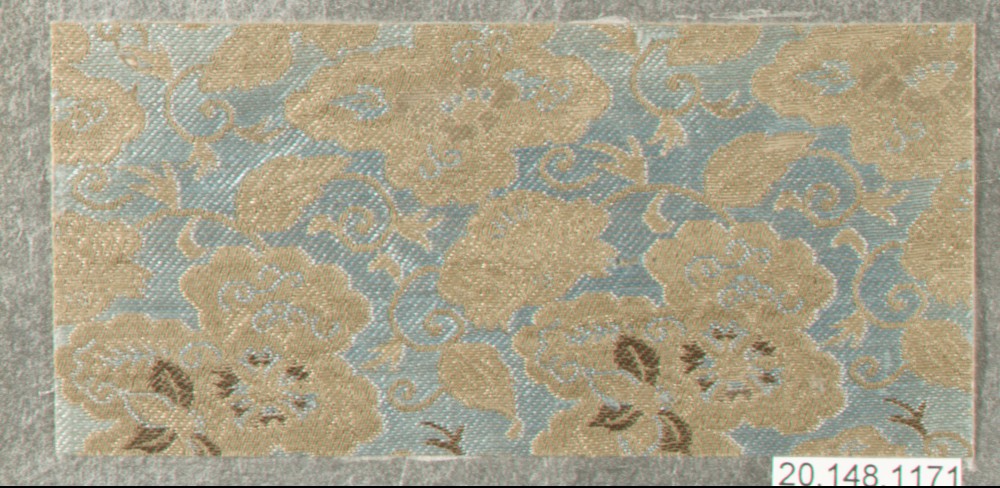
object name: piece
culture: japanese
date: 1801-1900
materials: silk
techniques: compound weave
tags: flowers,leaves